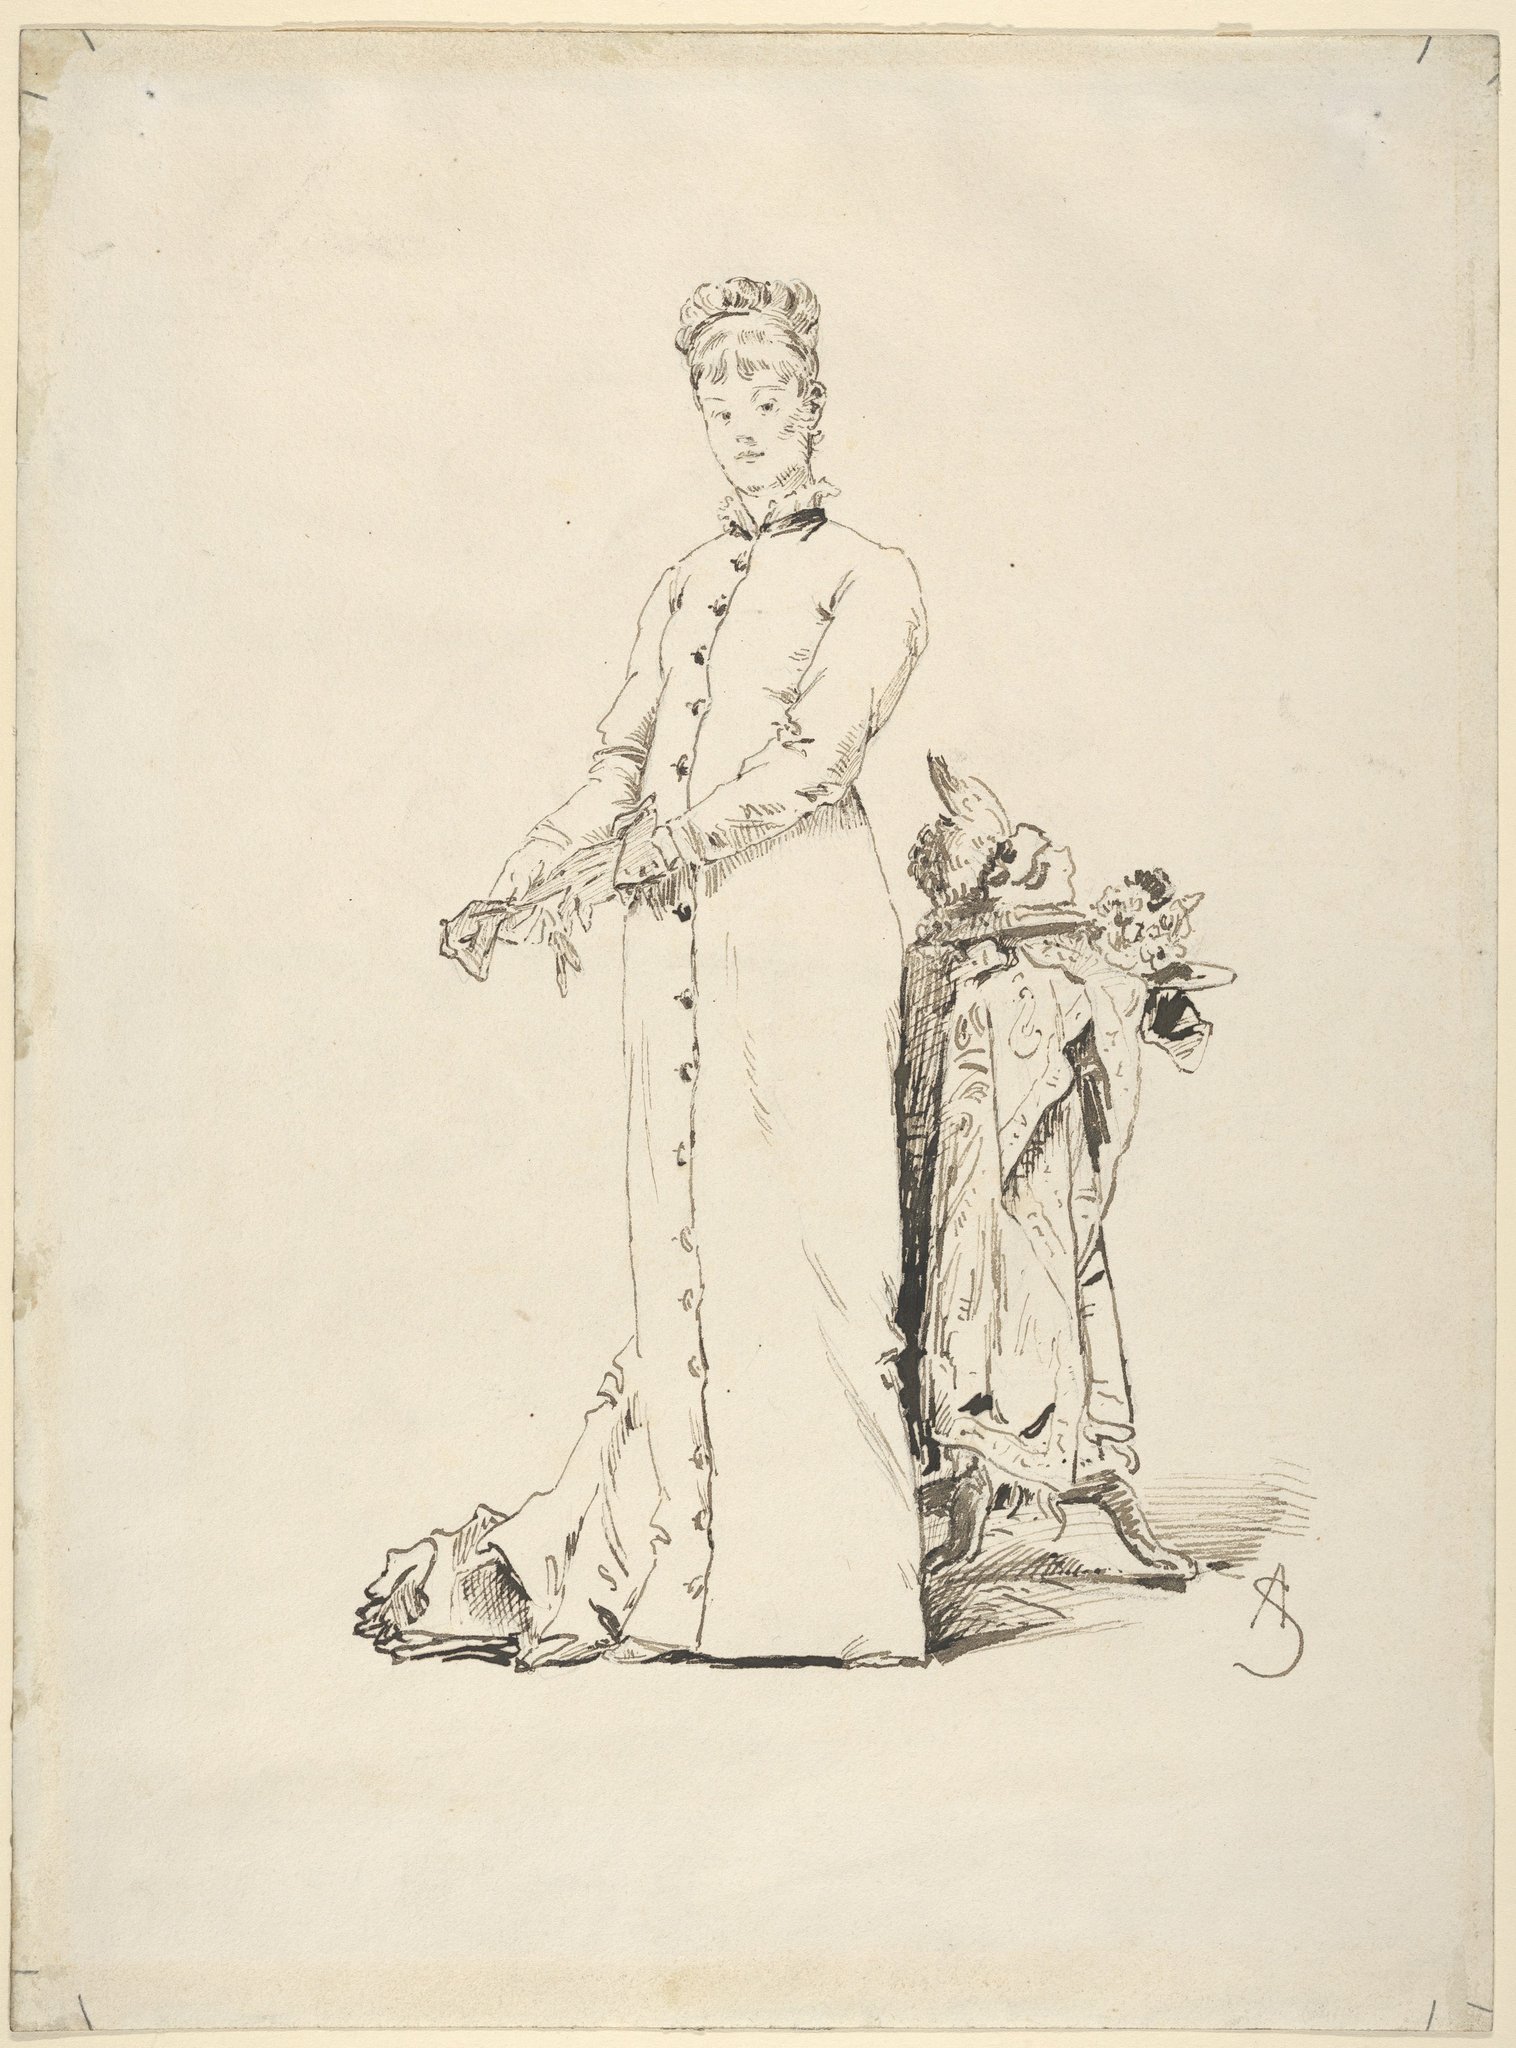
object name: drawing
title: A Standing Young Lady Taking Off Her Gloves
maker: alfred stevens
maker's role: artist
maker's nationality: belgian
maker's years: 1823-1906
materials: graphite, ink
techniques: pen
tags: women